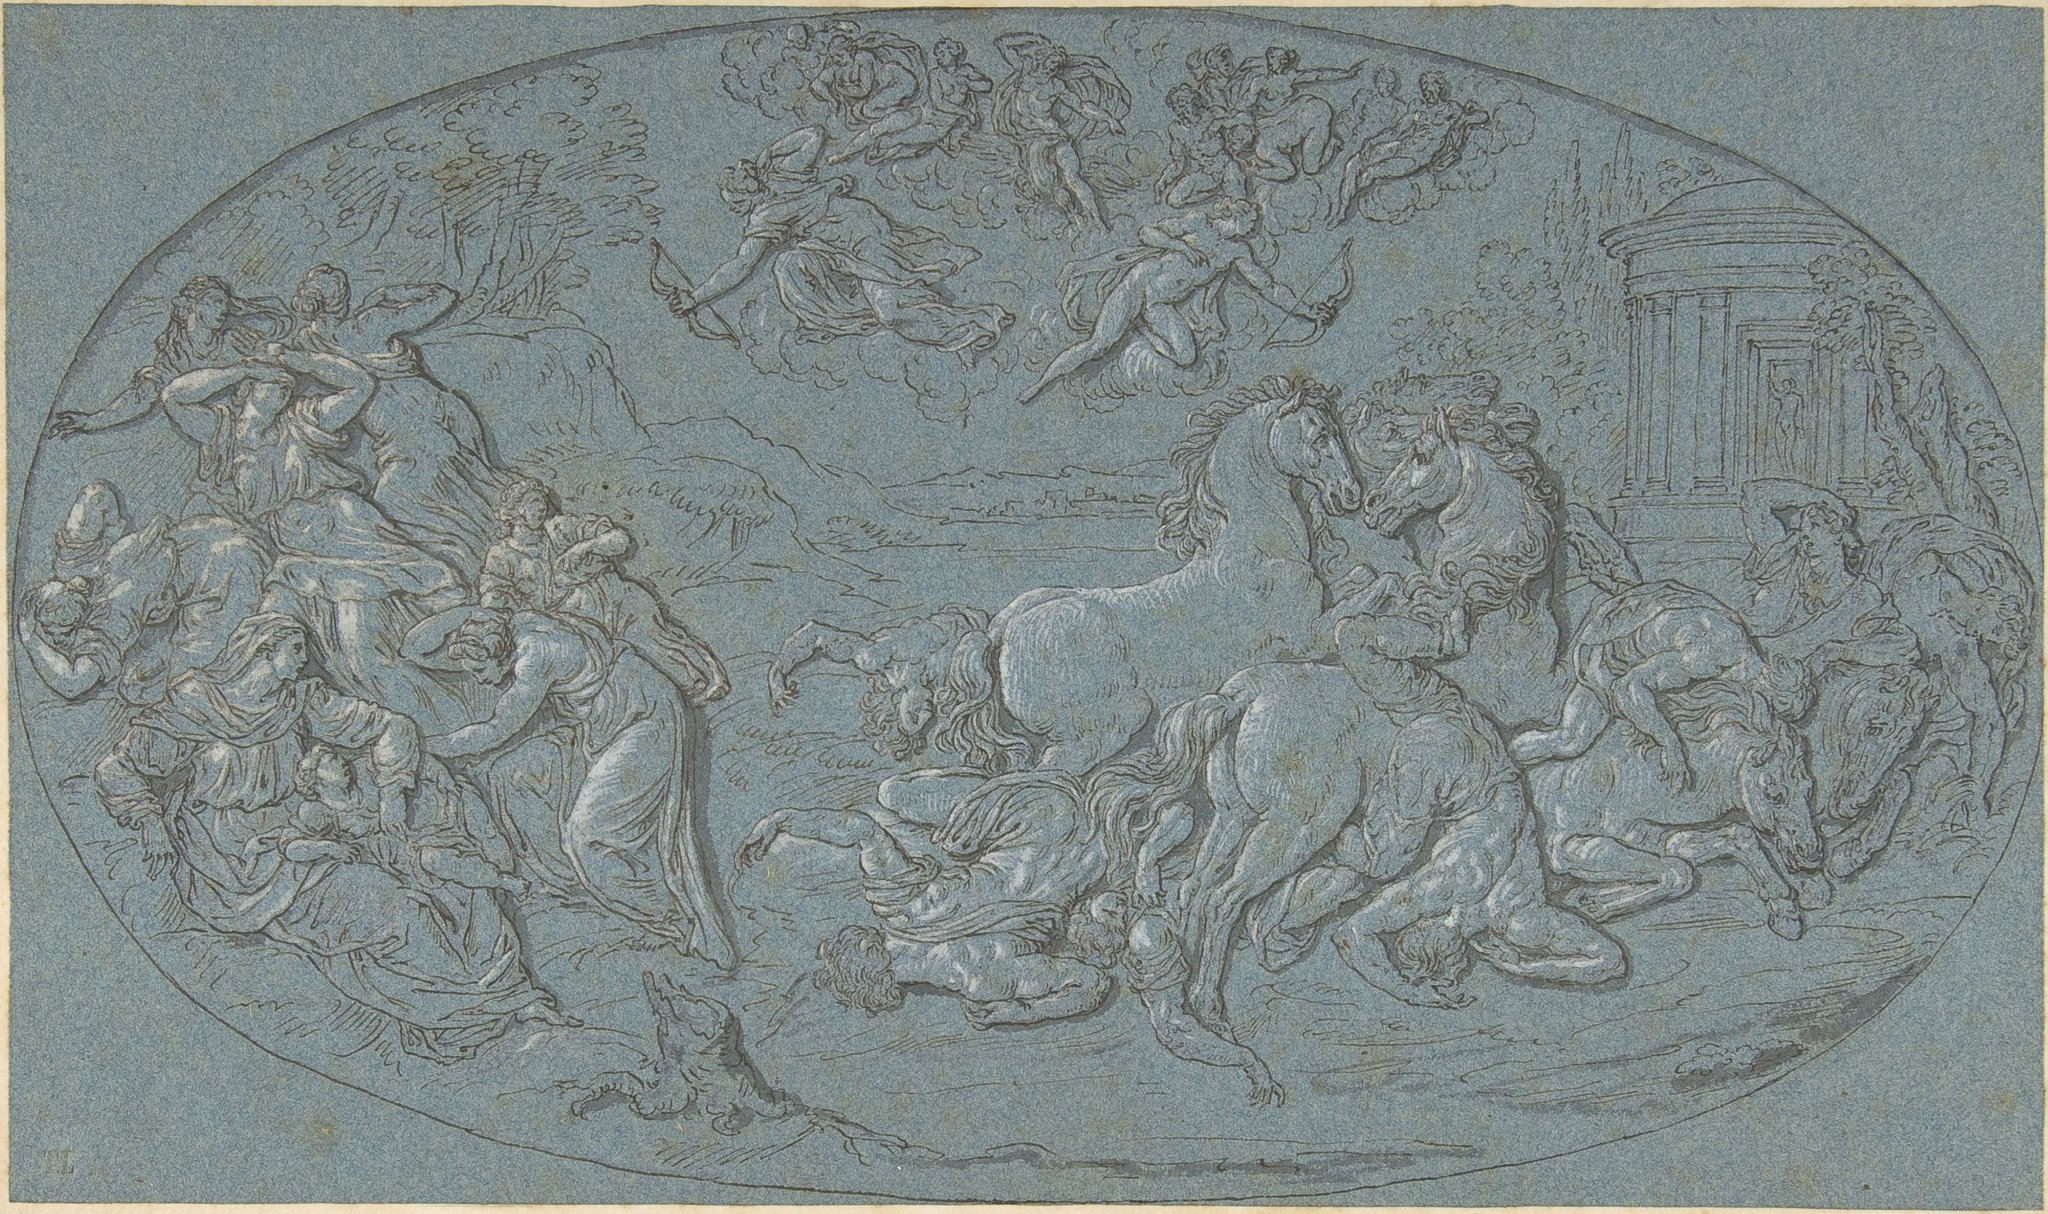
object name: drawing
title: Death of Niobe and Her Children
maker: bernard picart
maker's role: artist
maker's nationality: french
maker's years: 1673-1733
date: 1667-1733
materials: ink, paper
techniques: brush, heightening, pen, wash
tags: men,women,horses